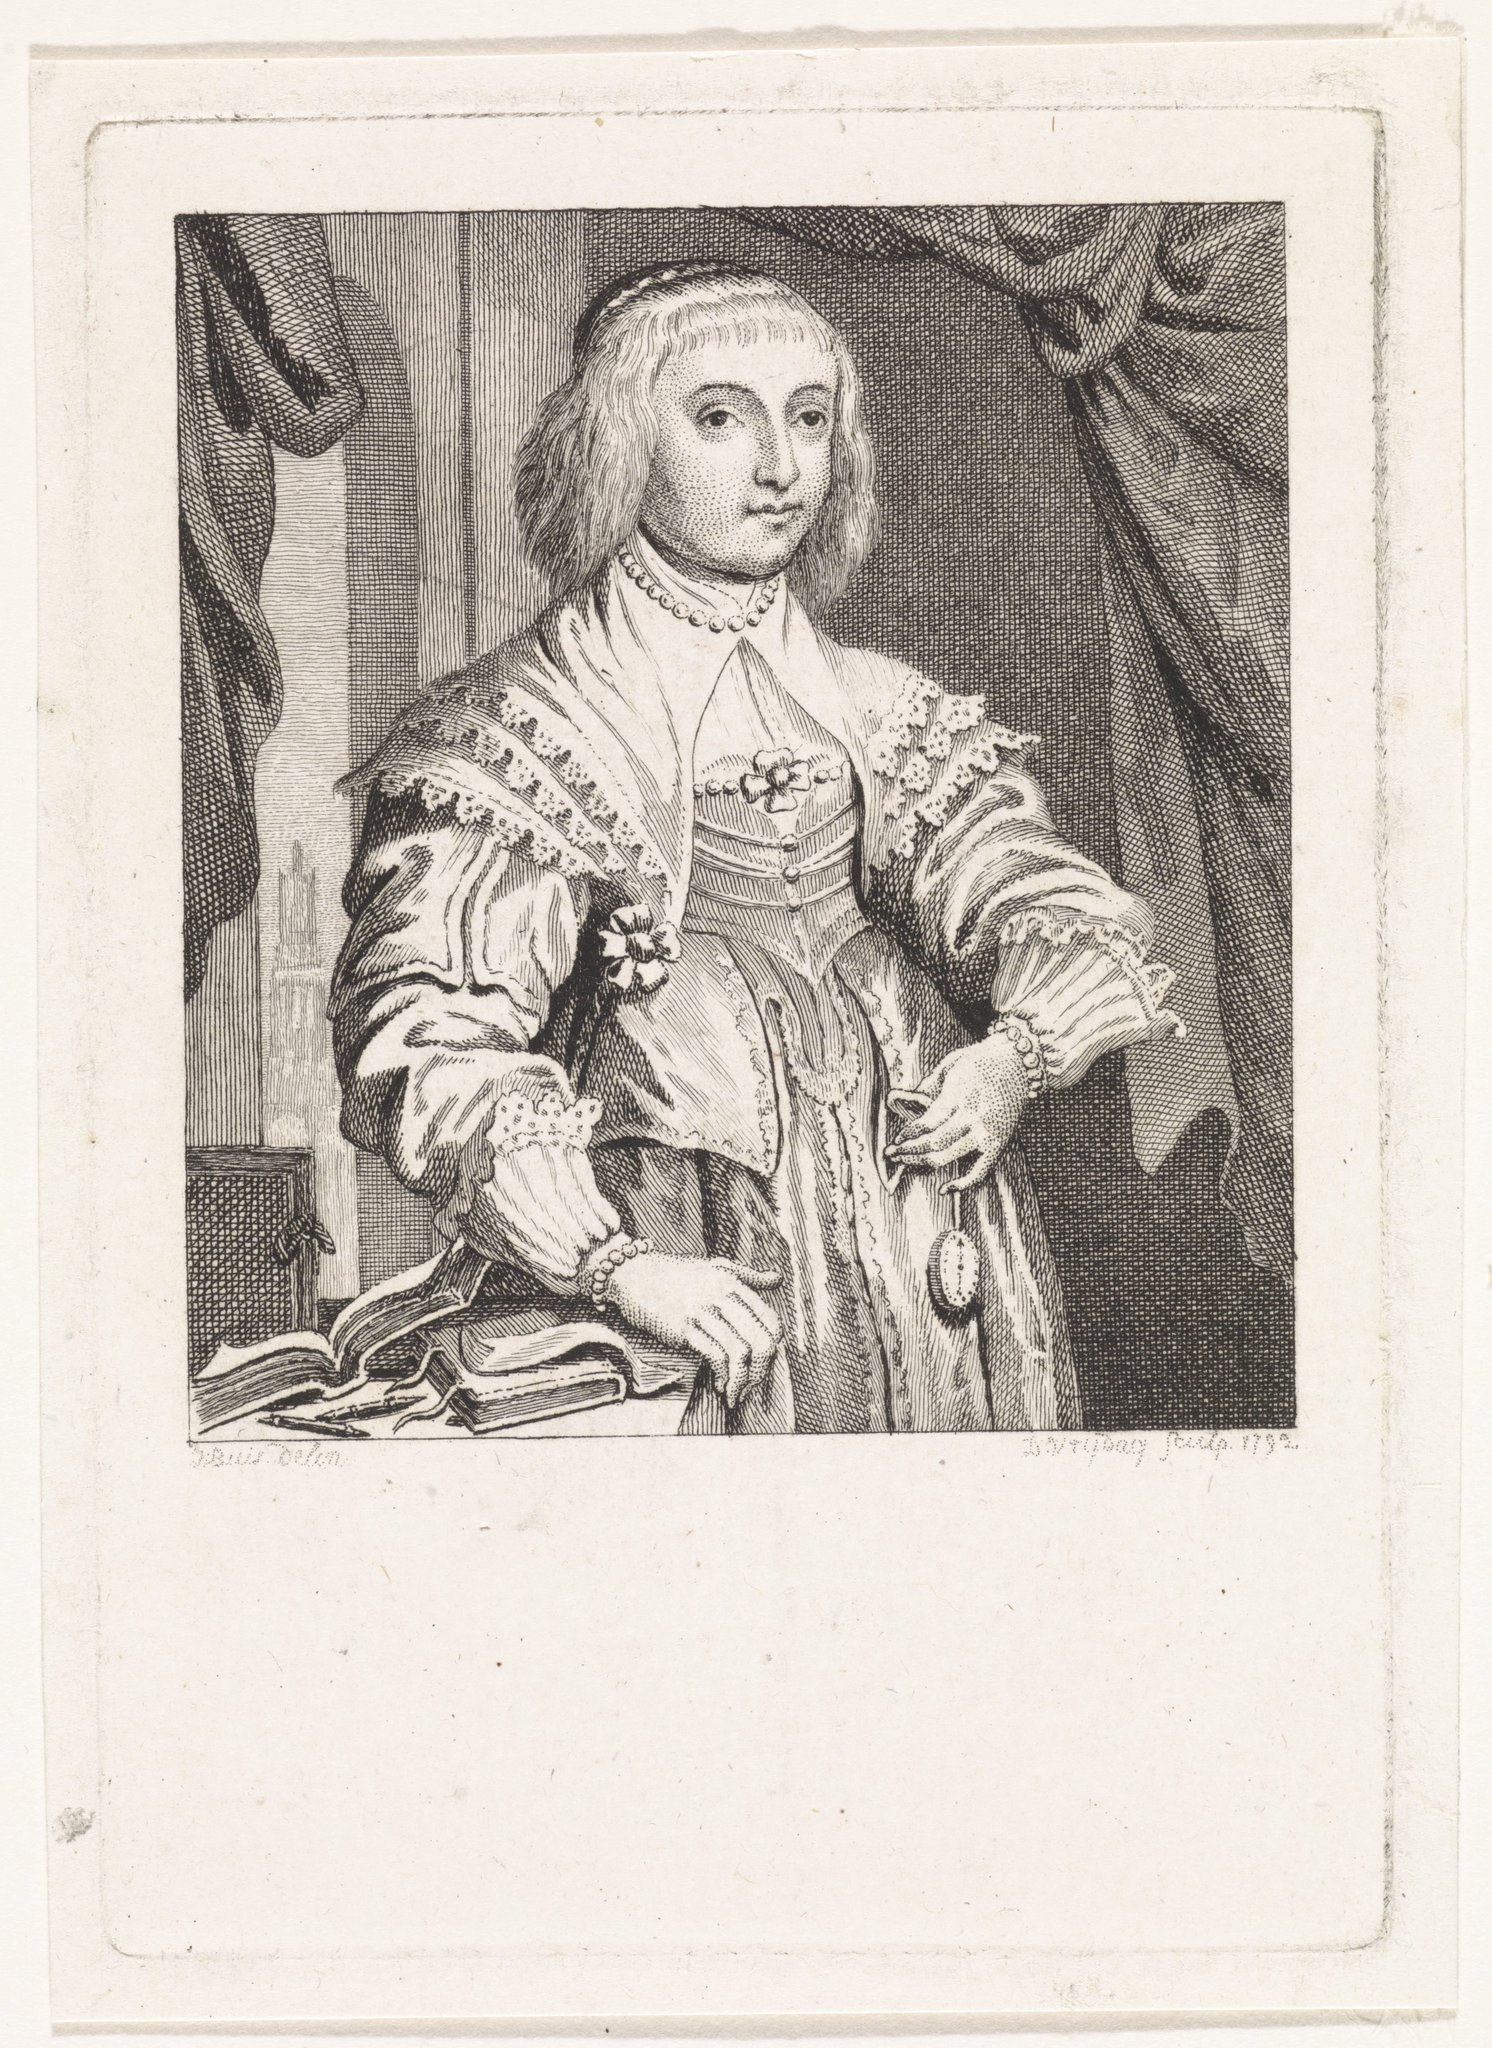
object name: print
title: Portret van onbekende dame met horloge in hand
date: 1792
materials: paper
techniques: engraving, etching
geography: amsterdam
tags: watch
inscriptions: collector's mark: Lugt 2228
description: Portret van dezelfde dame als op RP-P-1906-1479.